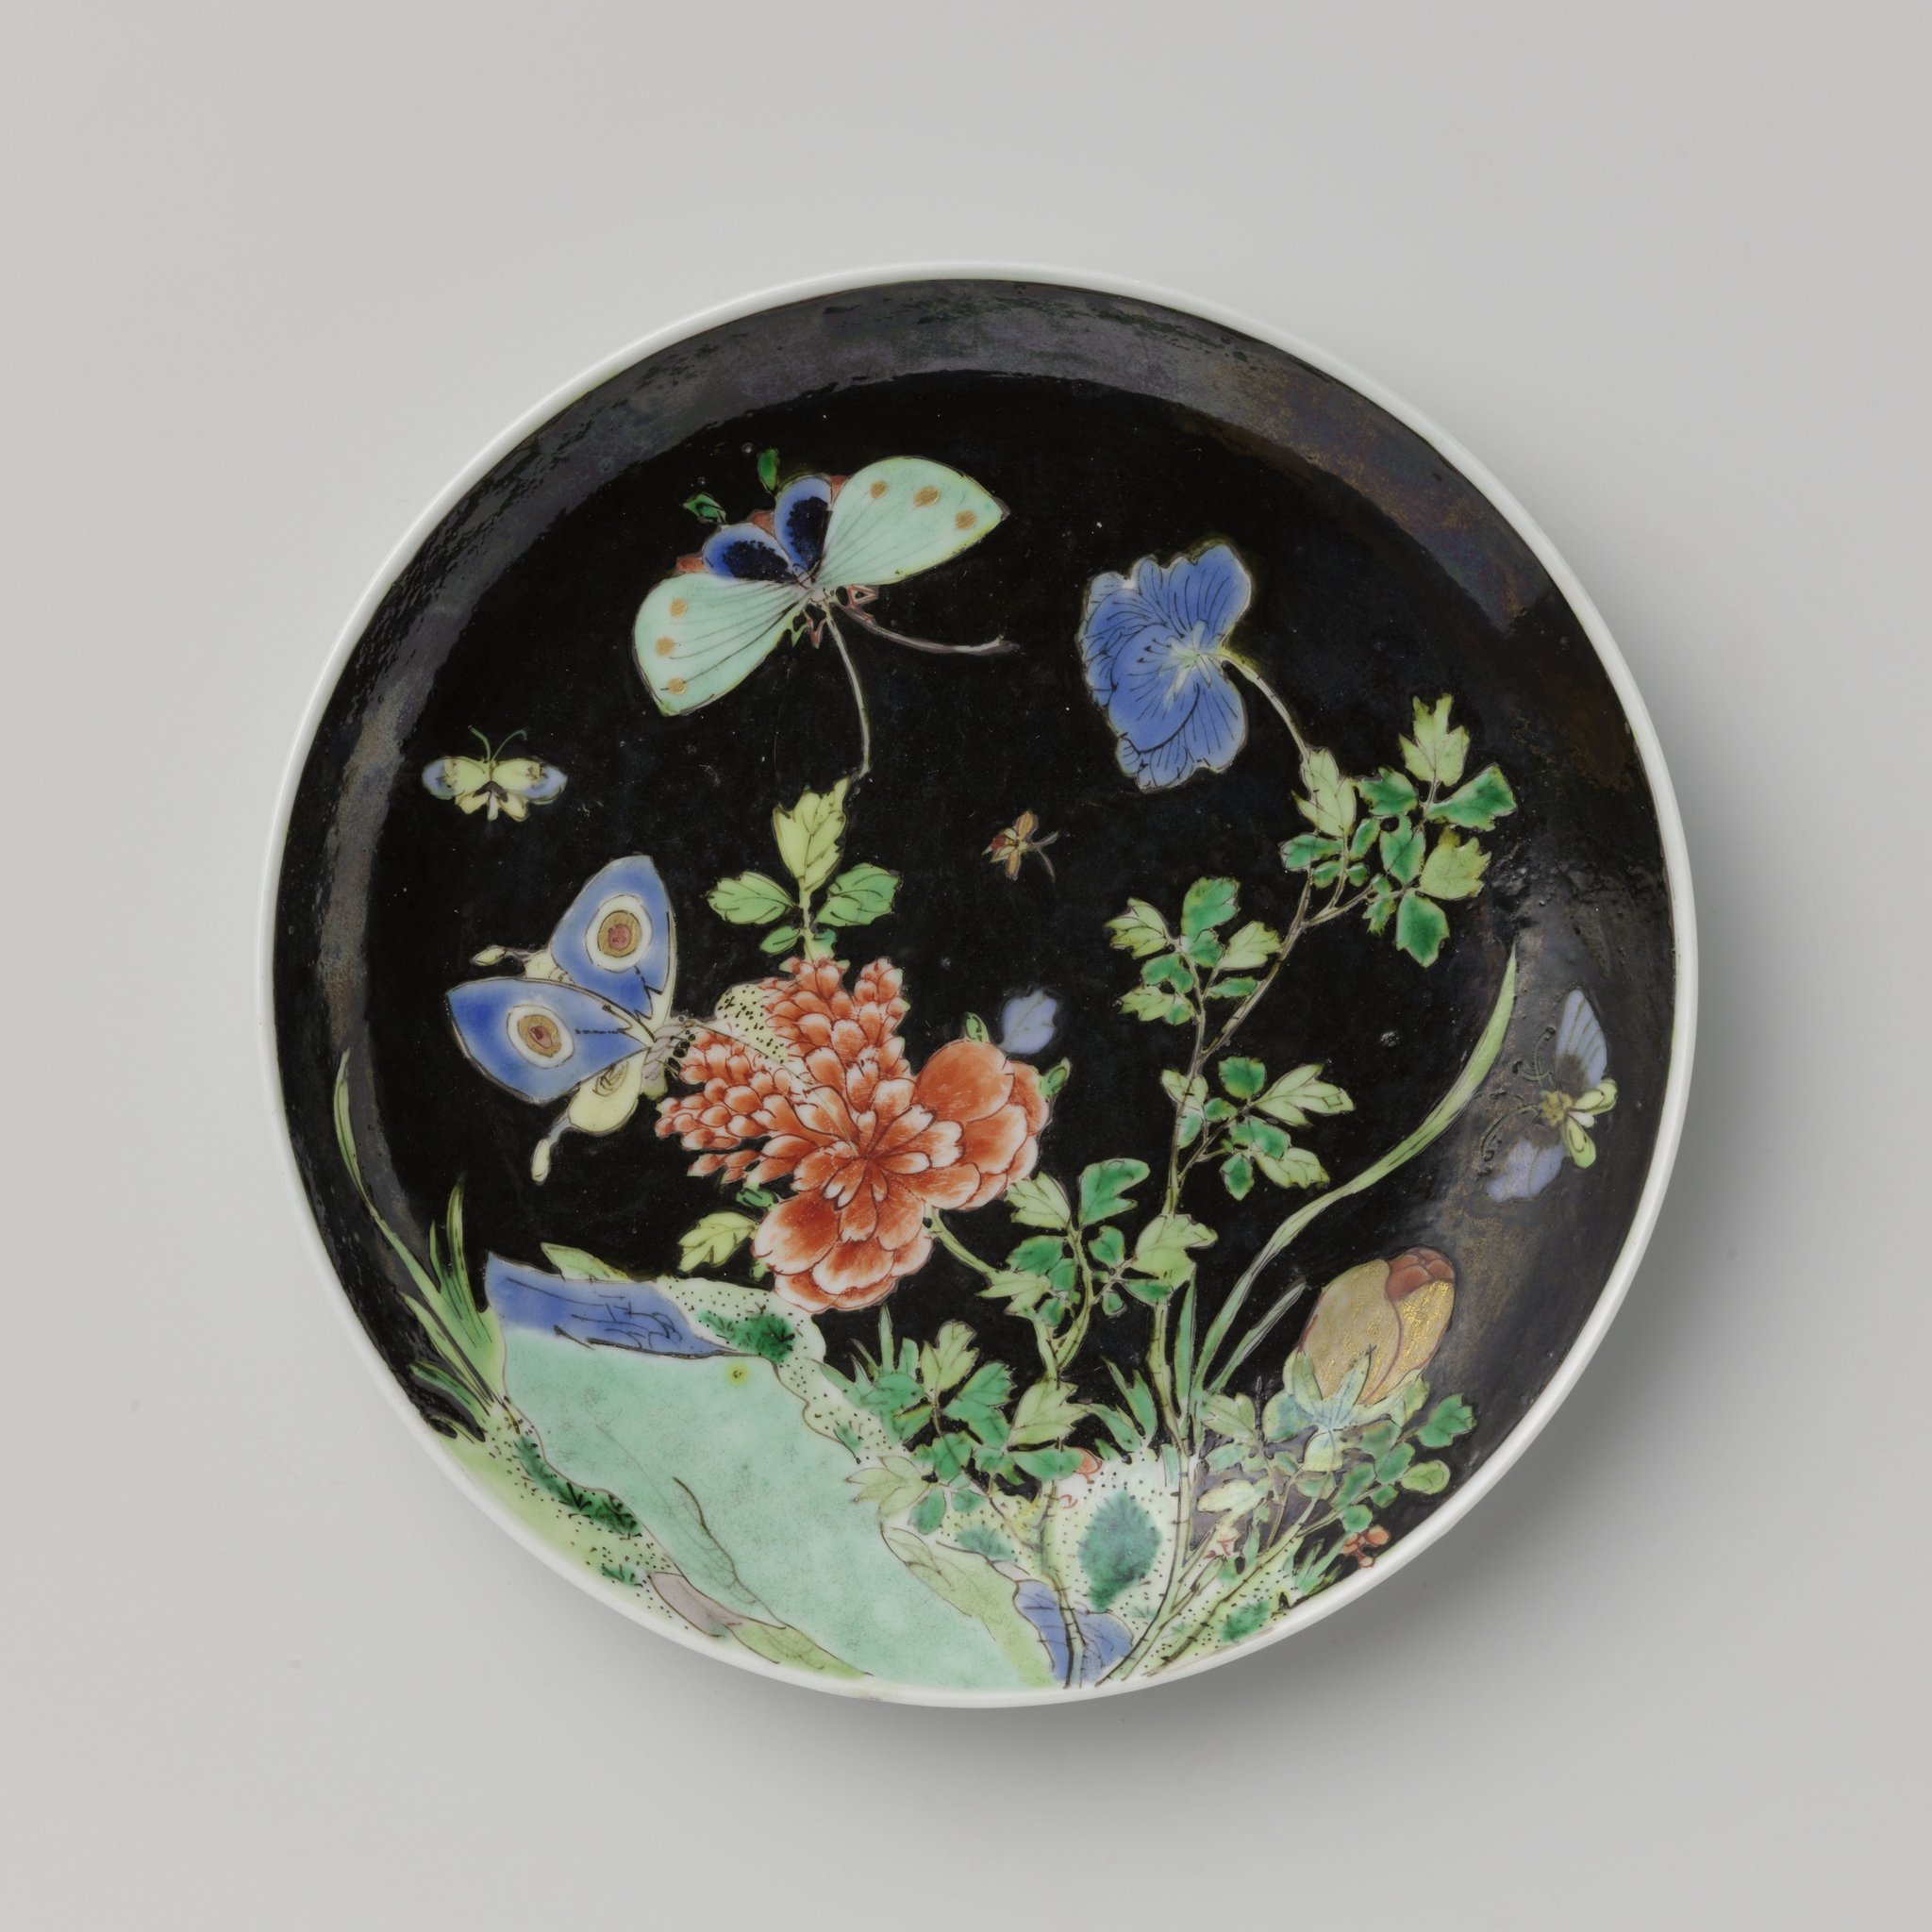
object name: platter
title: Saucer with butterflies and flowering plant near a rock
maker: Anonymous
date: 1700-1724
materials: cobalt, glaze, gold, paint, porcelain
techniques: firing, gilding, turning, vitrification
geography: china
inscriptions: mark: ‘大 清 康 熙 年 製 dà qīng Kāng xī nián zhì’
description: Schotel van porselein met ronde wand, beschilderd in onderglazuur blauw en op het glazuur blauw, rood, groen, geel, aubergine, zwart en goud. Op het plat een doorlopende voorstelling van vliegende vlinders bij een bloeiende plant naast een rots, tegen een zwarte achtergrond. Gemerkt op de onderzijde met het zes-karaktermerk van keizer Kangxi in een dubbele cirkel. Famille noire.